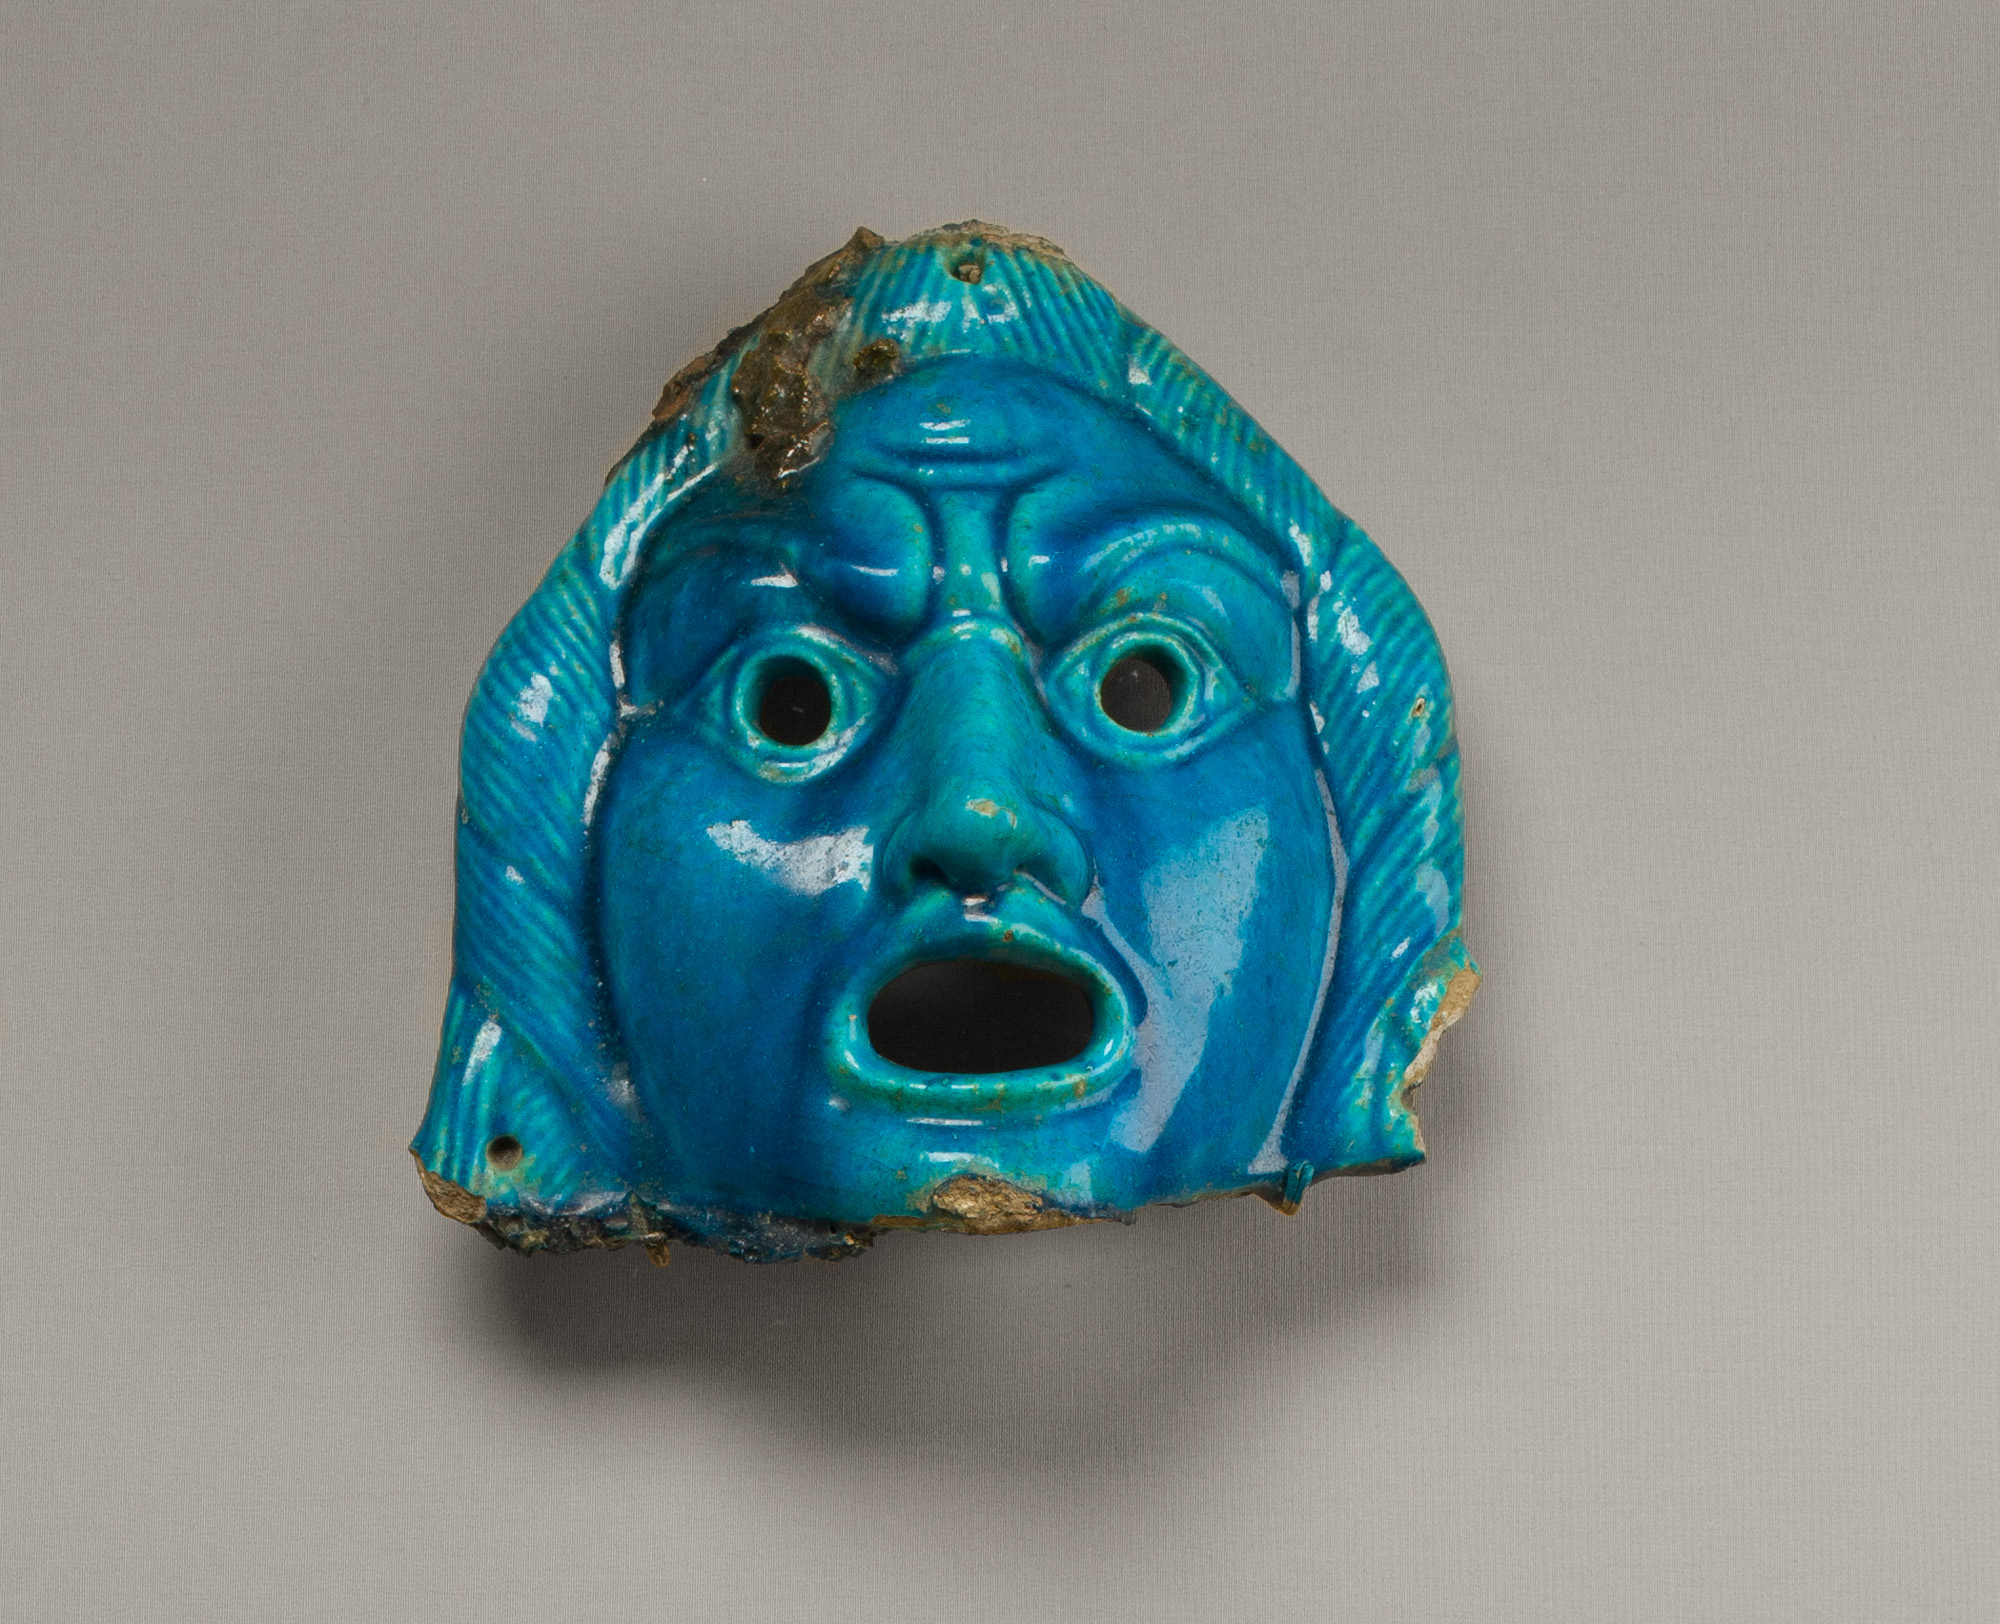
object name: mask, theatrical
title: Theatrical mask for offering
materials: faience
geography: fayum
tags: masks